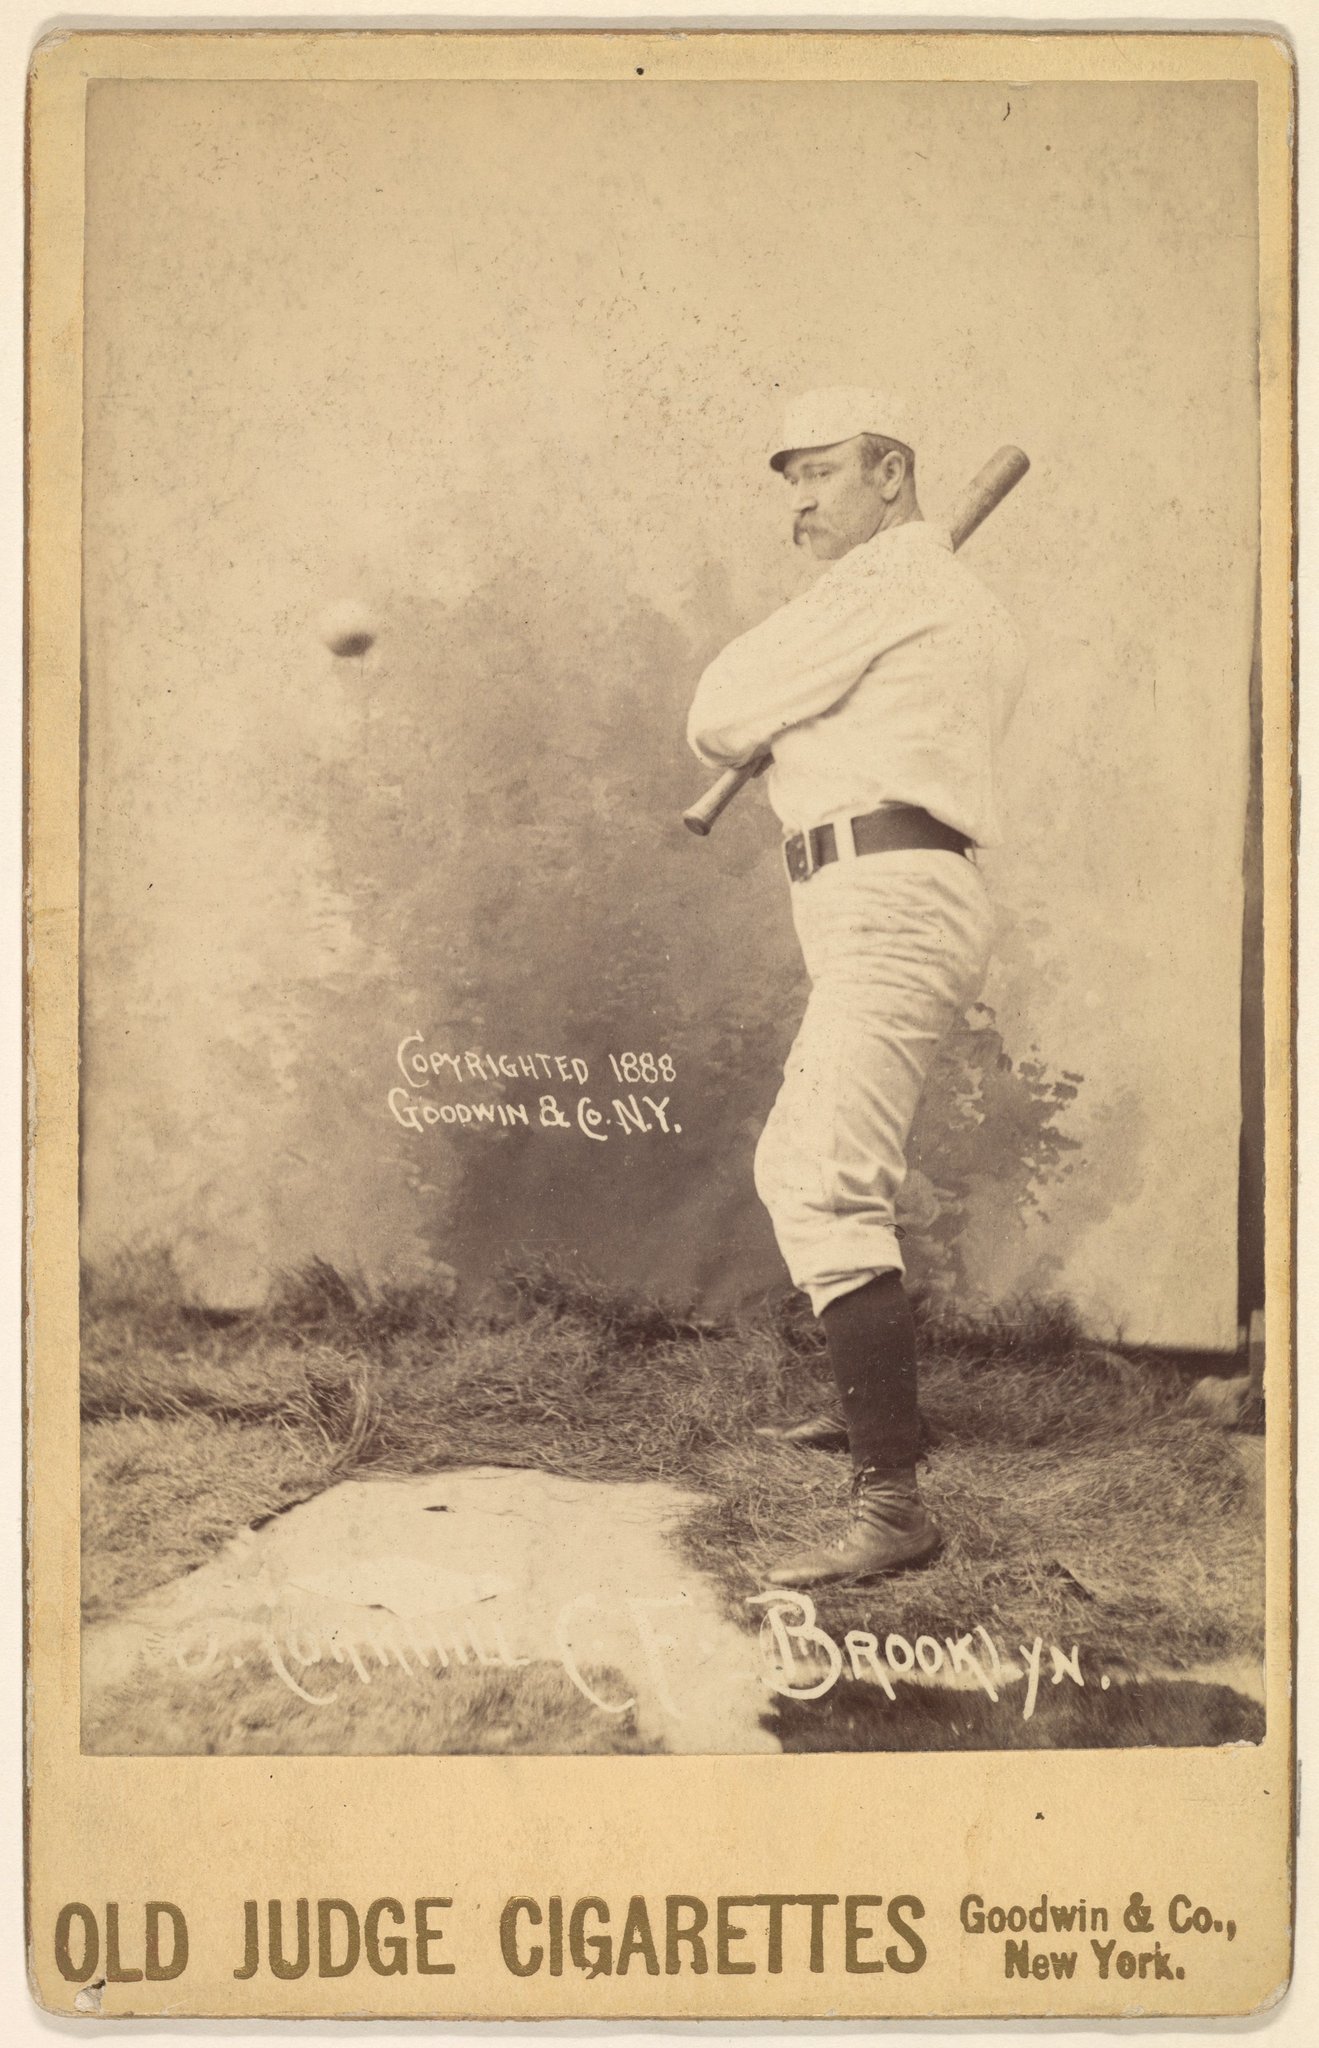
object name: baseball card, photograph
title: John Stewart "Pop" Corkhill, Center Field, Brooklyn, from the series Old Judge Cigarettes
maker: goodwin & company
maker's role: publisher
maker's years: 1850-1950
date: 1888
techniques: albumen silver print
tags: men,portraits,baseball,athletes